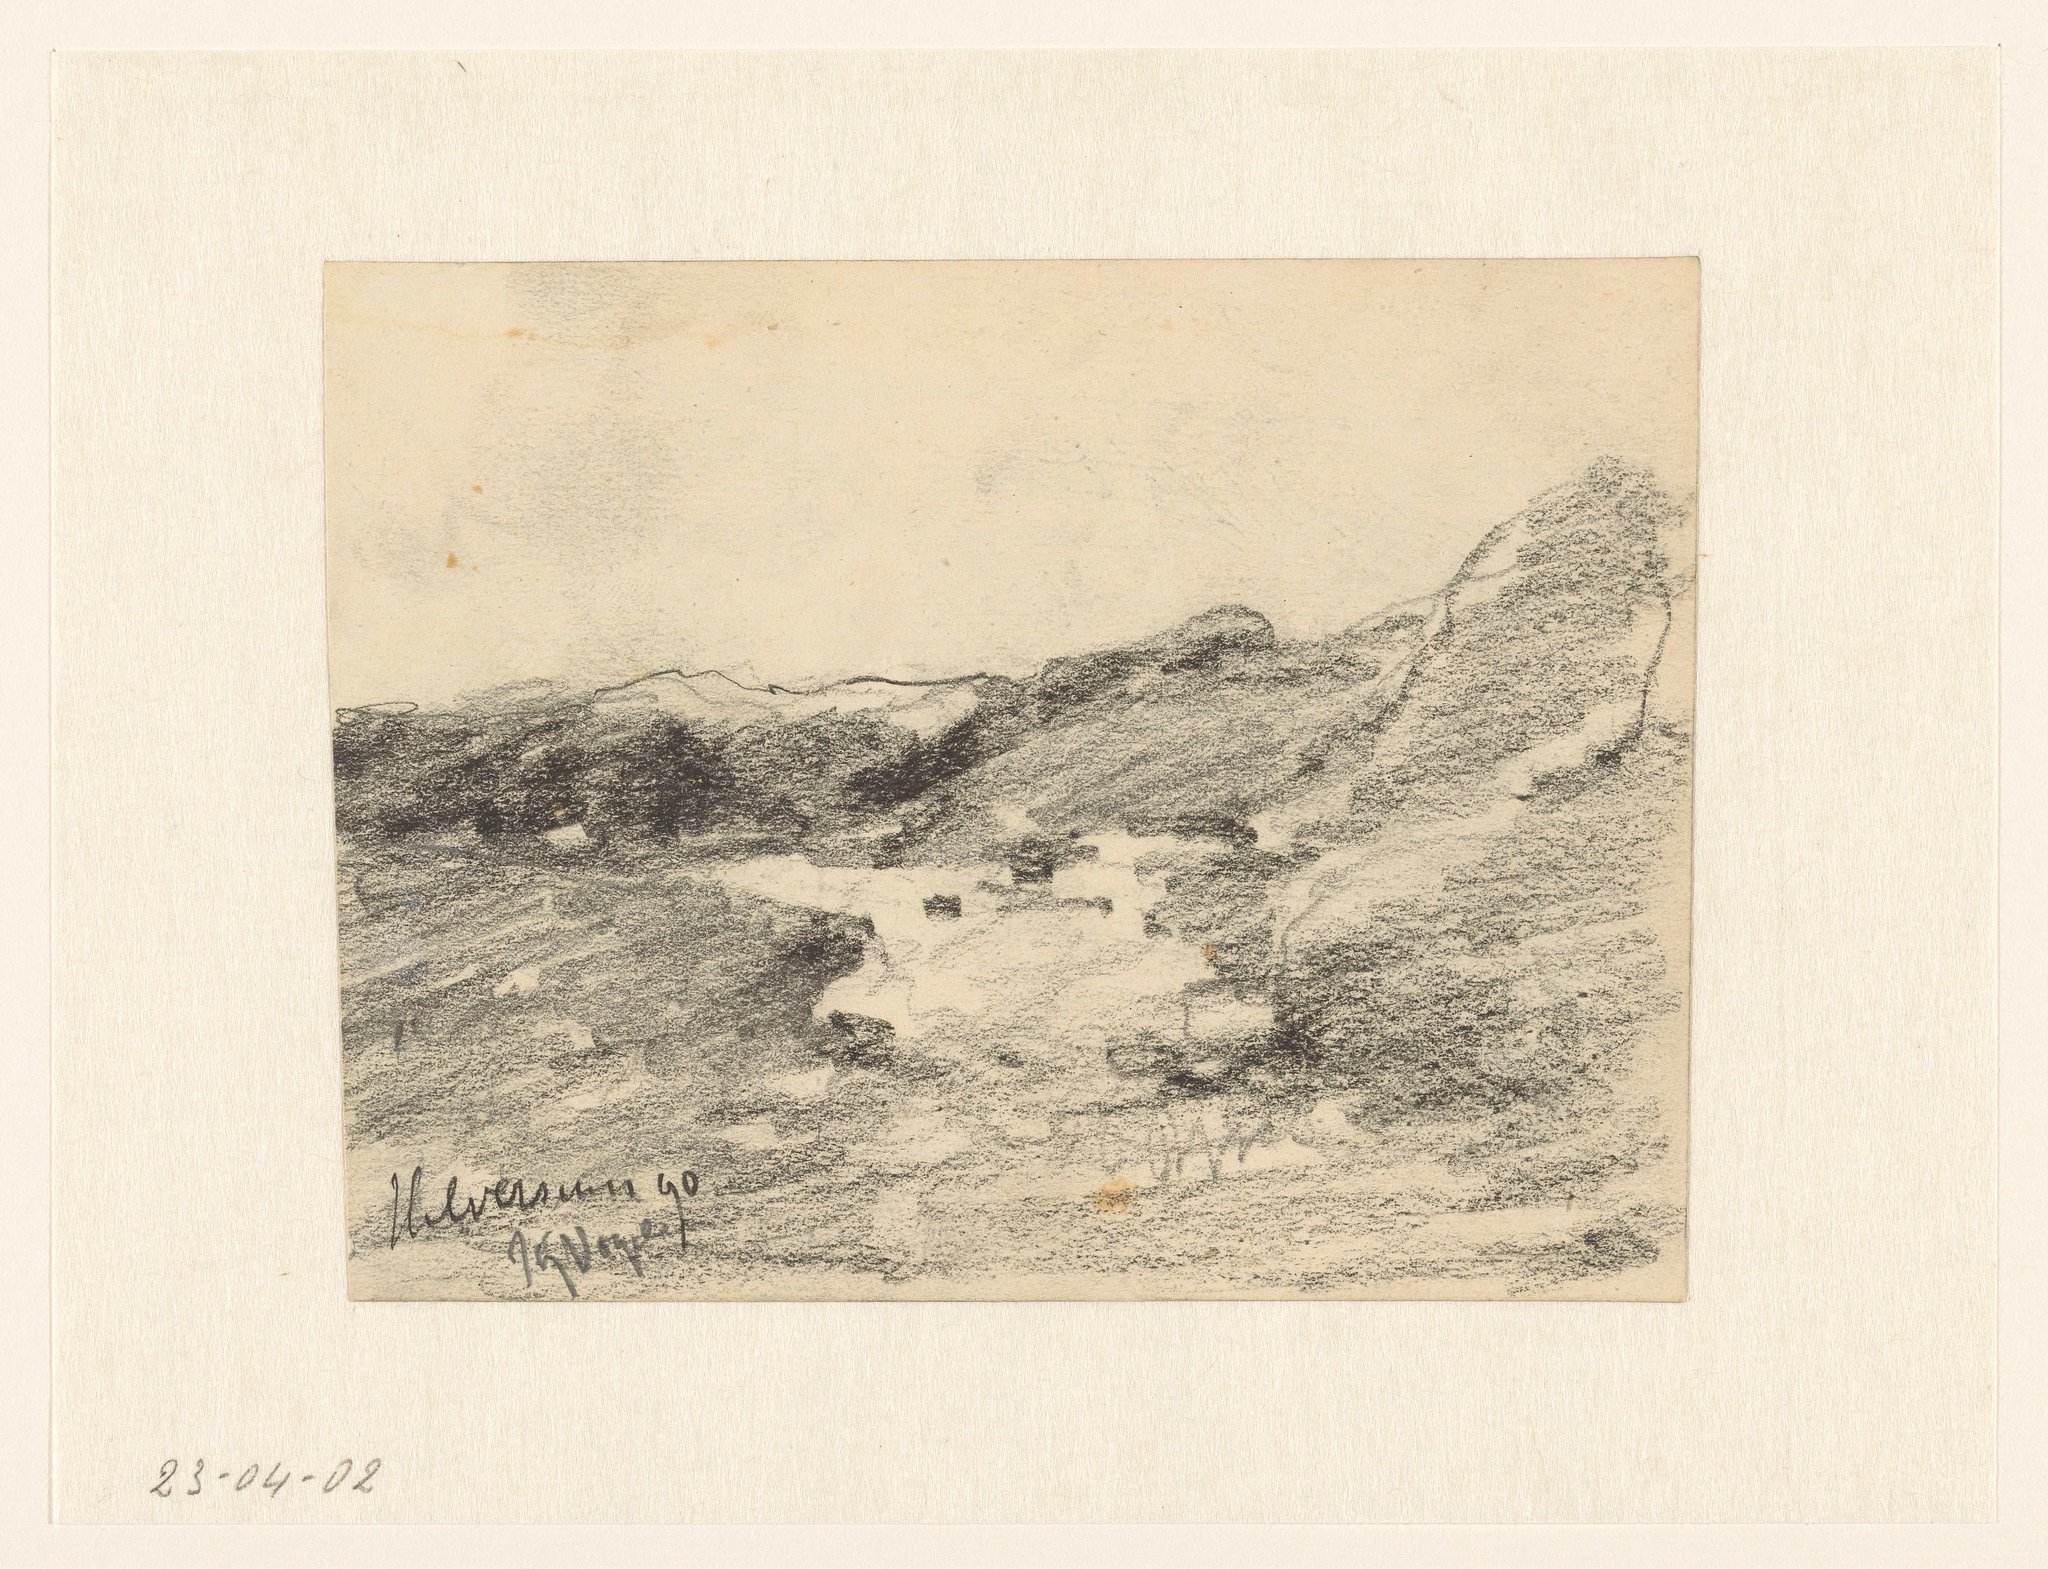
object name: drawing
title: Landschap bij Hilversum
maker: johannes gijsbert vogel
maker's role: draughtsman, painter, print maker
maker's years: 1828-1915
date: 1890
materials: chalk, paper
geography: hilversum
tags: plain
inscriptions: date